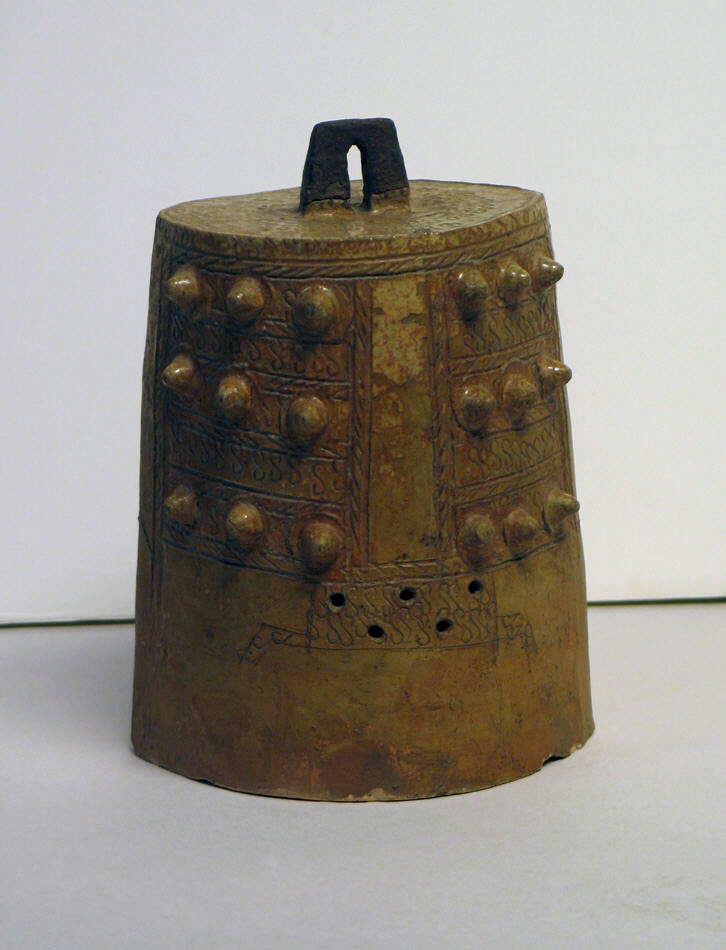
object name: ceramic model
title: Model of a bell (Niu Zhong)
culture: chinese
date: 500-201 BCE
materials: stoneware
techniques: glazing